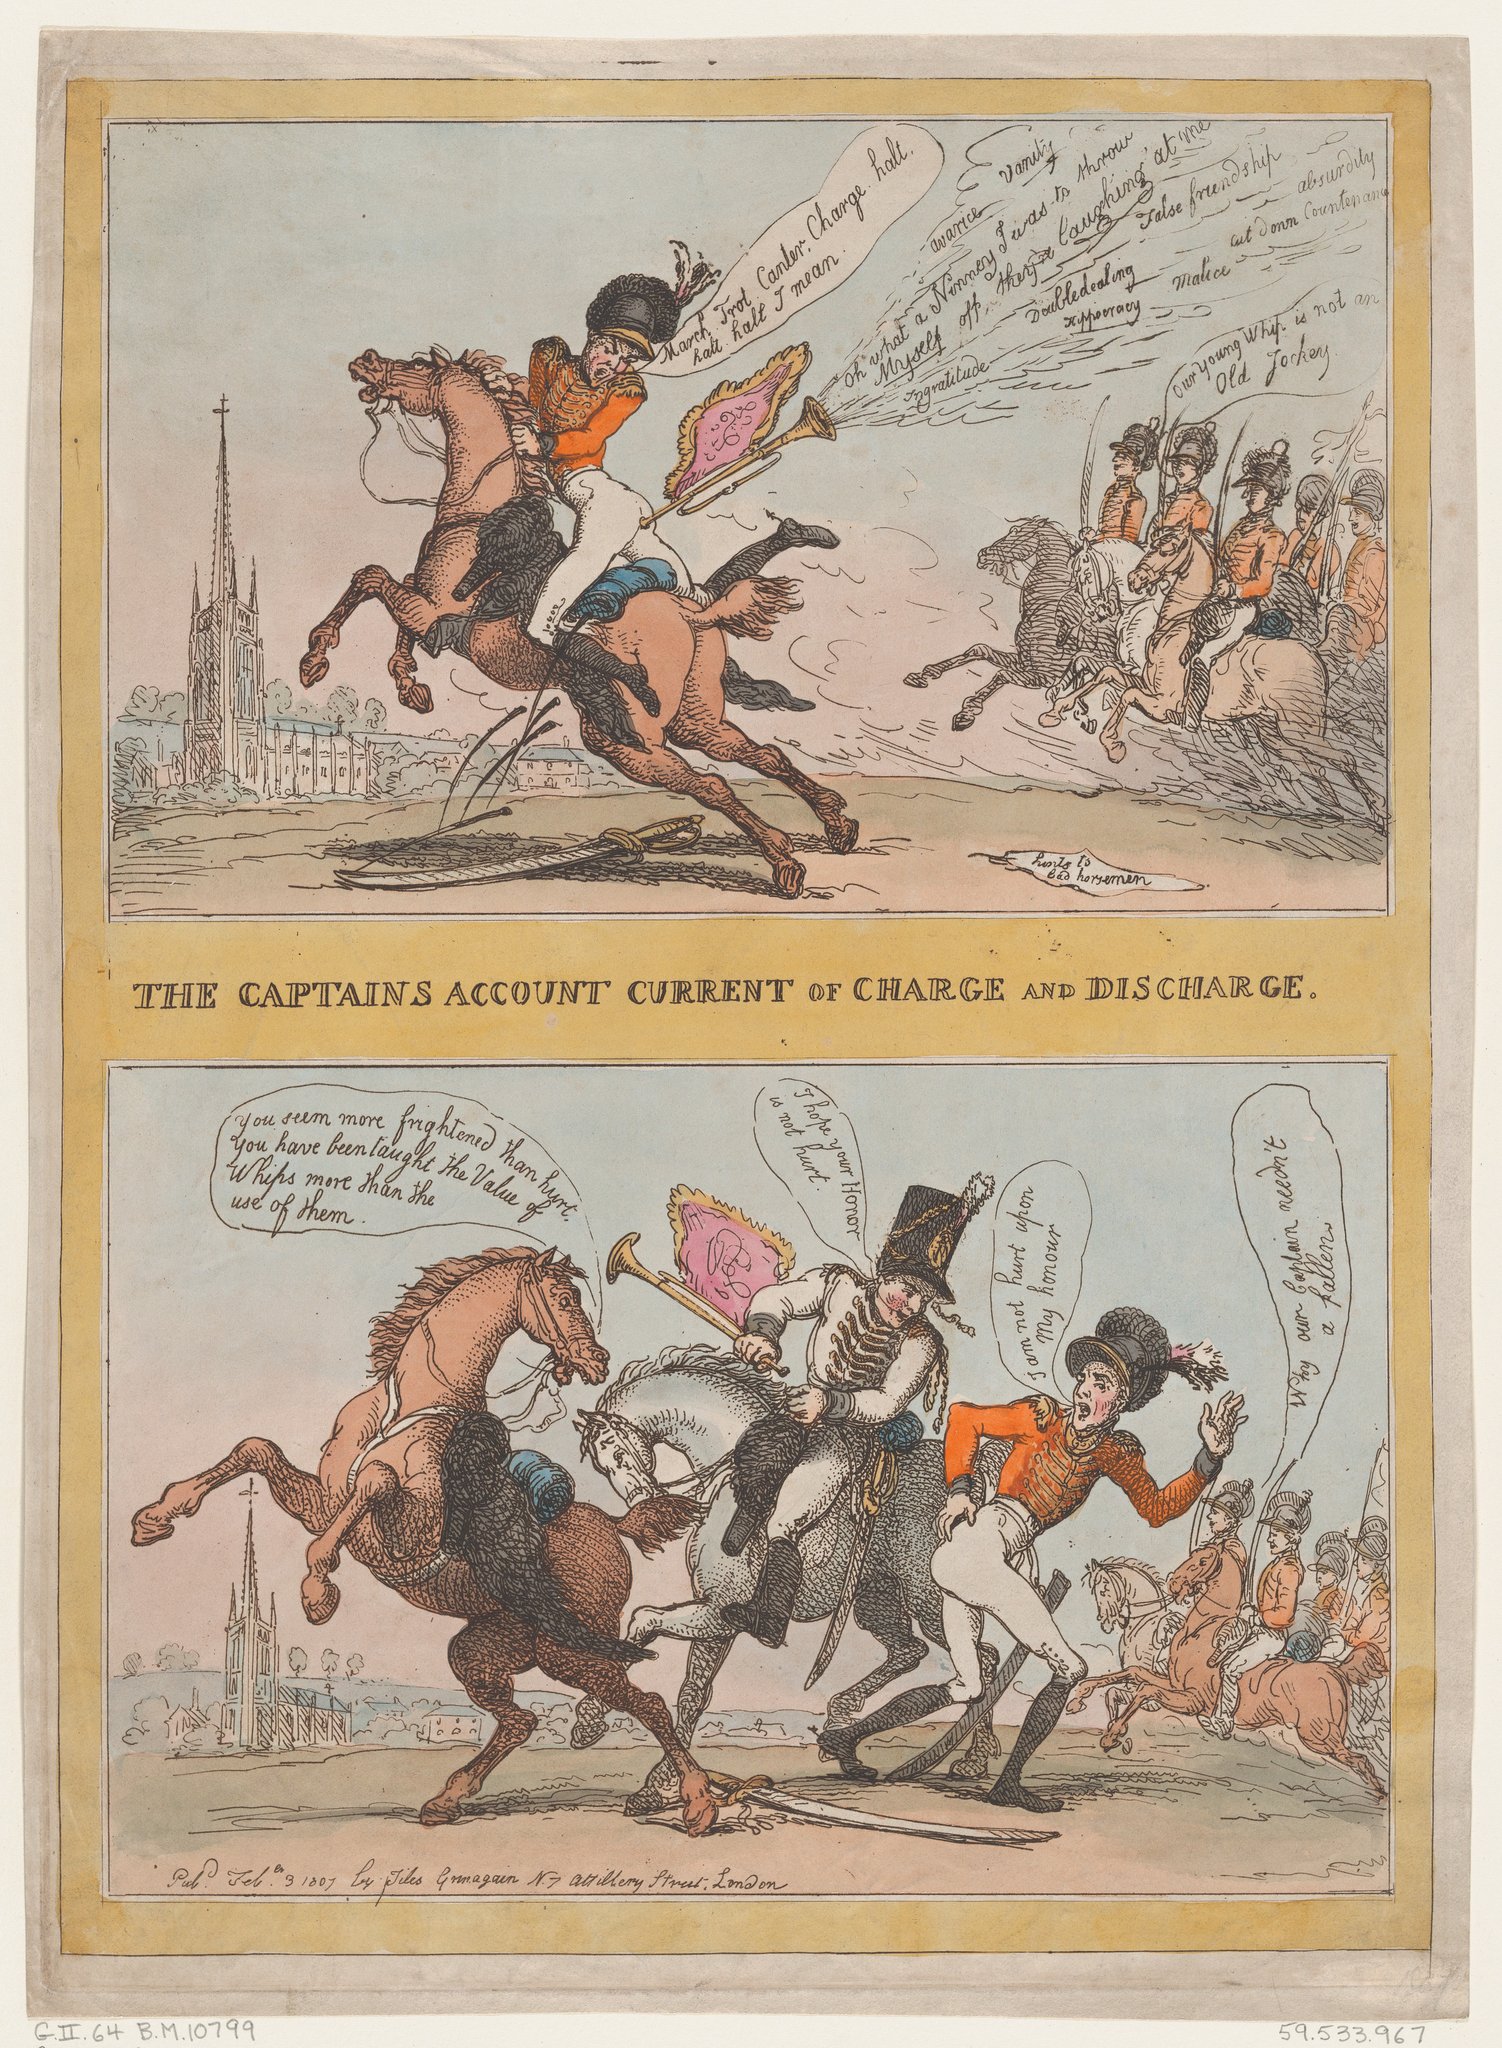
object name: print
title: The Captains Account Current of Charge and Discharge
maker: thomas rowlandson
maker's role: artist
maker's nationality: british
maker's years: 1757-1827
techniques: etching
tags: satire,men,horses